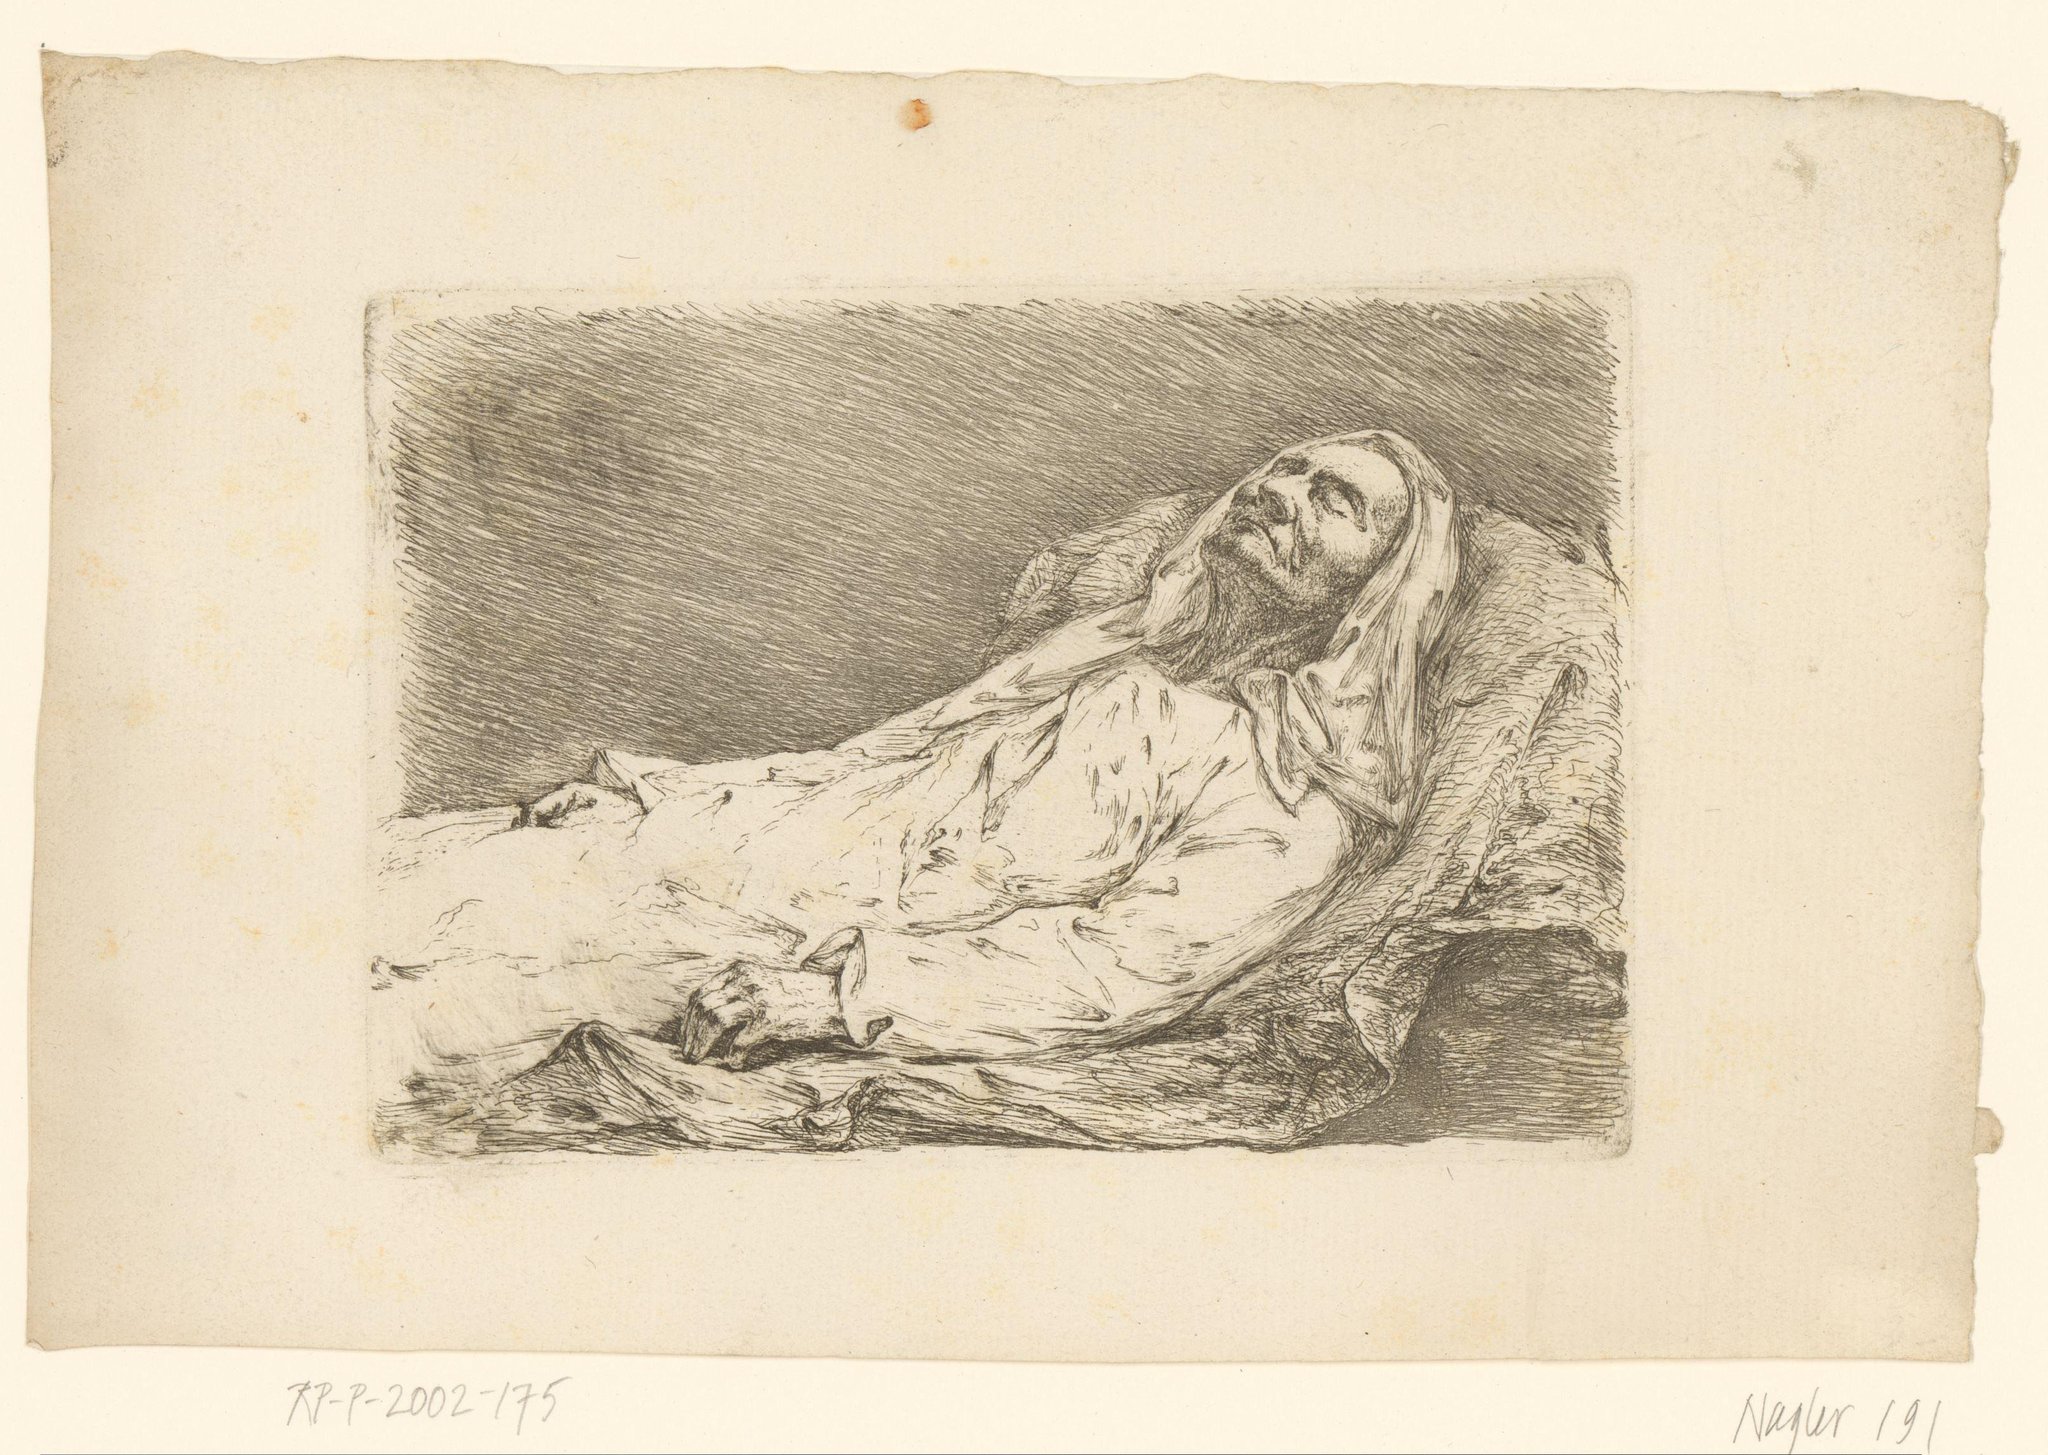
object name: print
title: Portret van vader Christian Bernhard Rode op zijn sterfbed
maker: bernhard rode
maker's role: artist, print maker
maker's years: 1725-1797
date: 1755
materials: paper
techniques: etching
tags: goldsmith, deathbed, historical persons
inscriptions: collector's mark: Lugt 3998, collector's mark: Lugt 2760, collector's mark: Lugt 2228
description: Verwerkt in schilderij 'Laatste Oordeel', ook als ets (RP-P-2004-426).